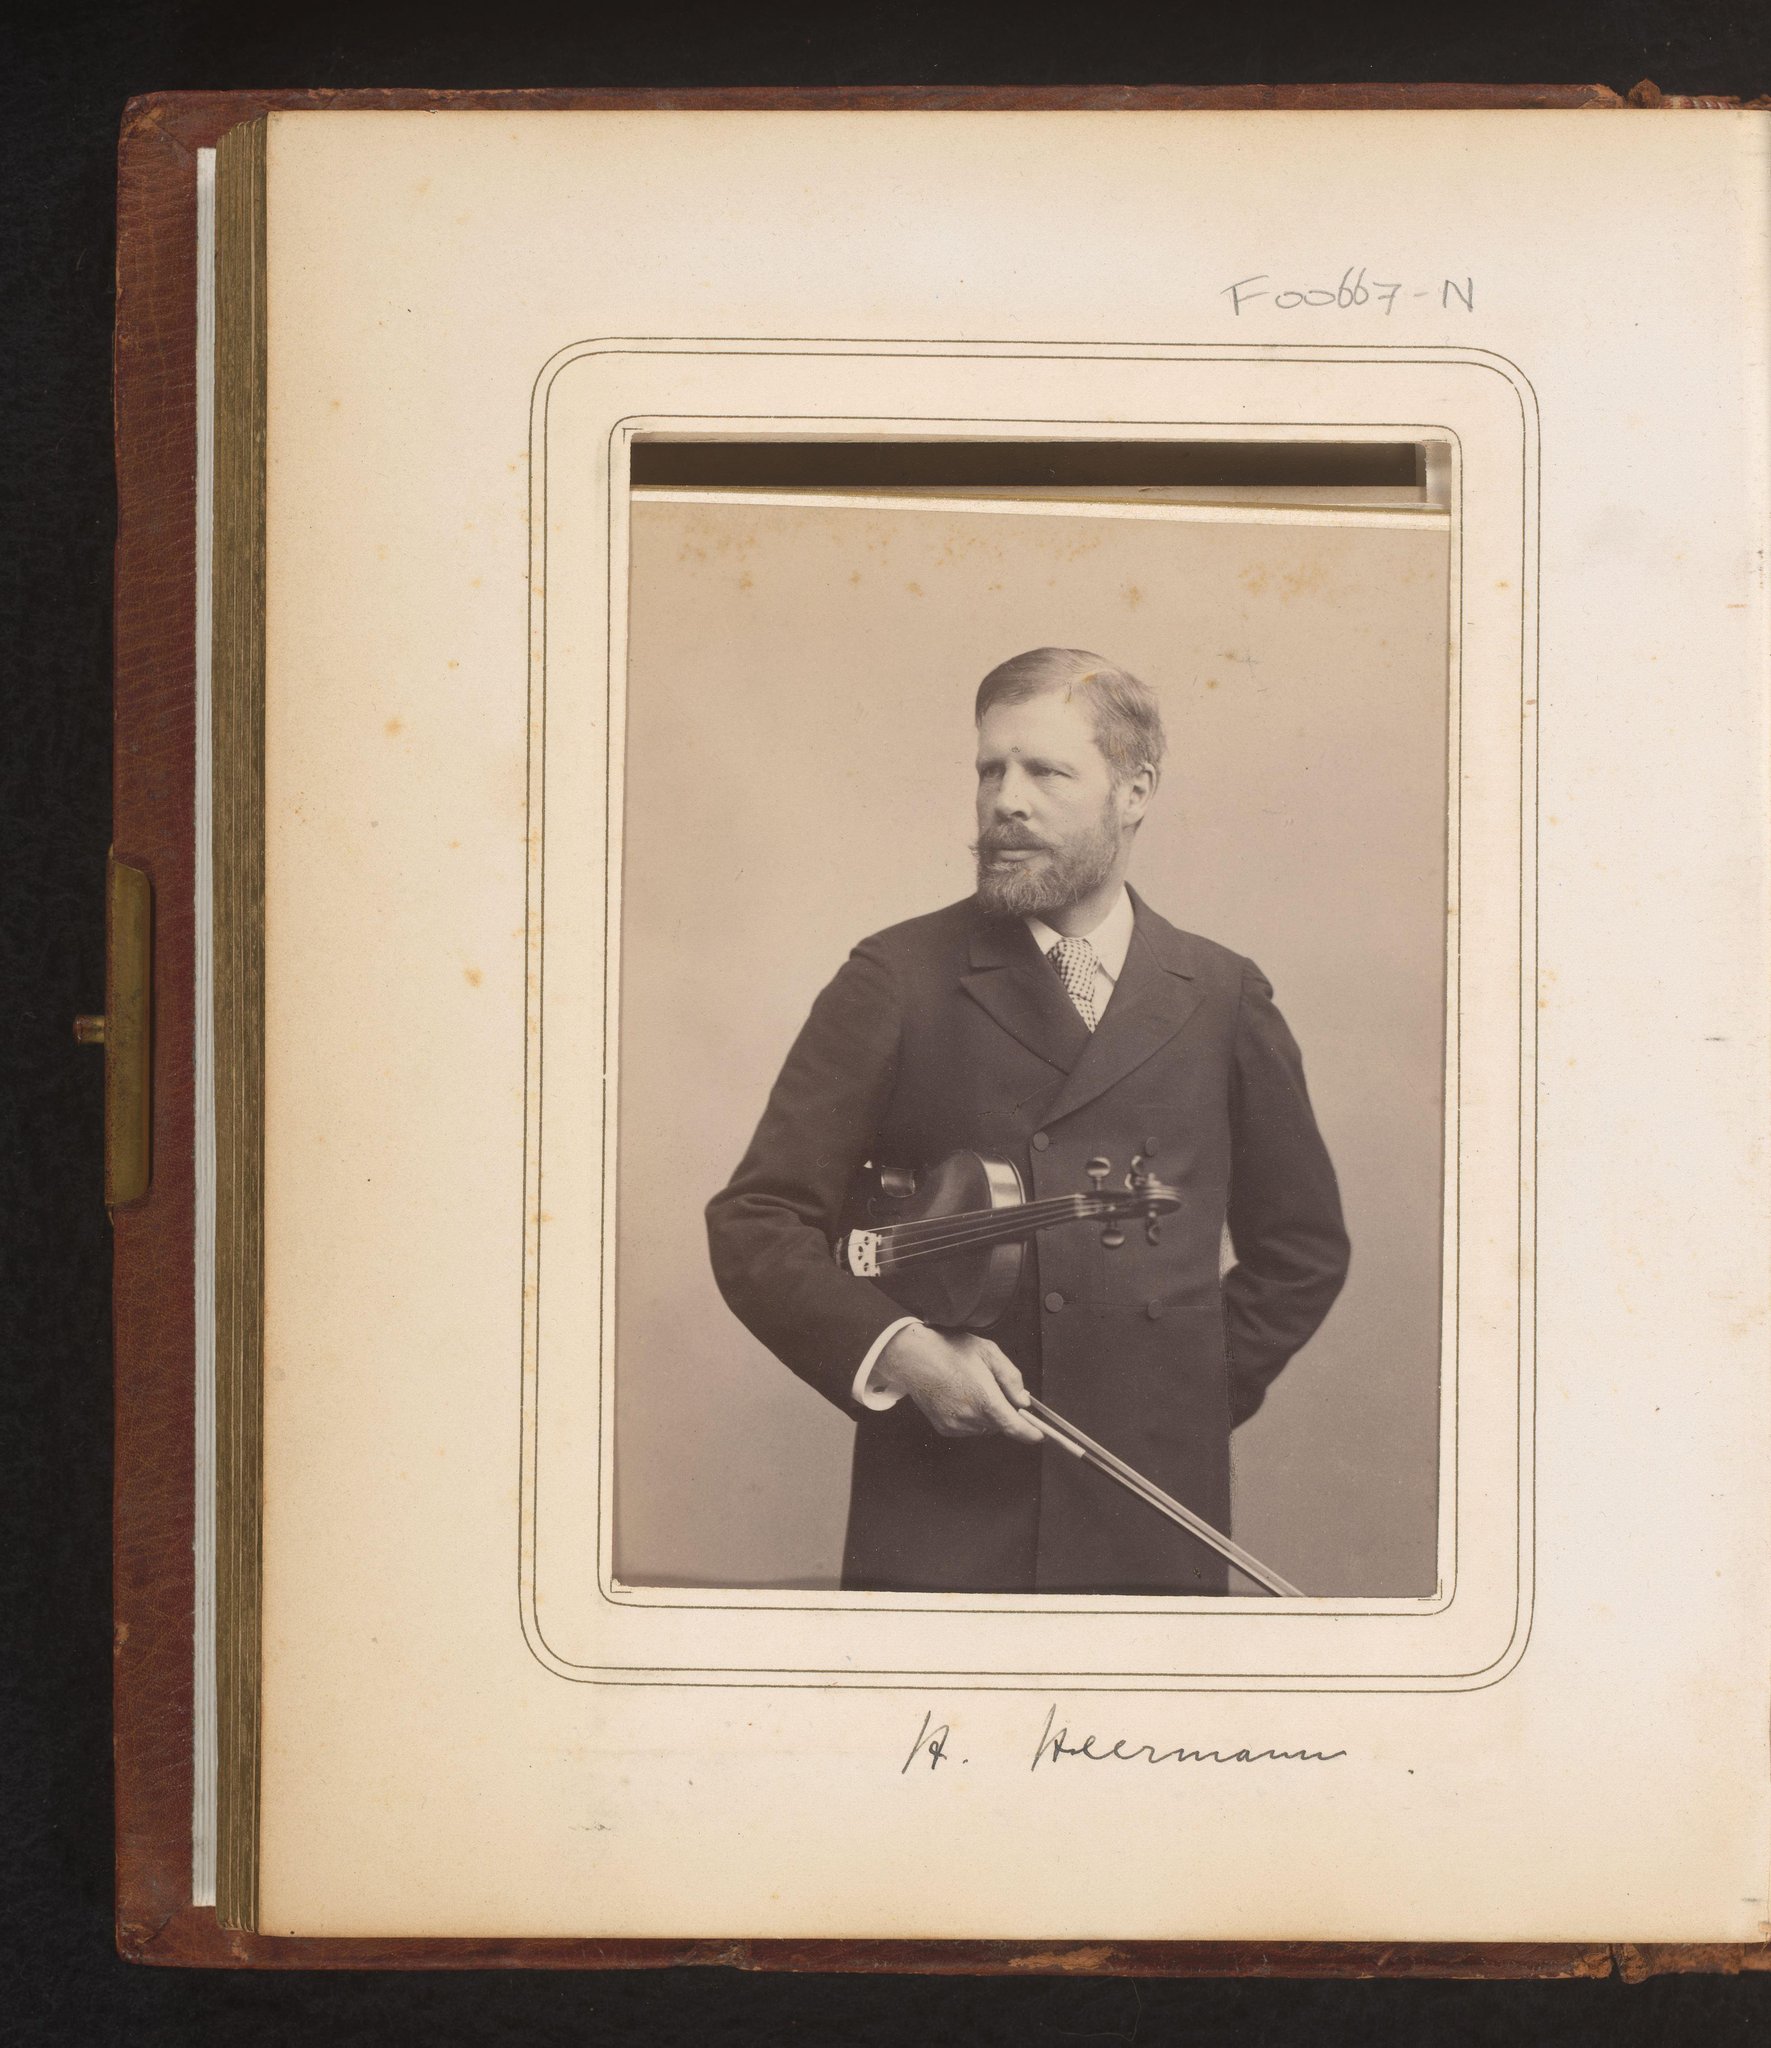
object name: album leaf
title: Portret van Hugo Heermann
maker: erwin hanfstaengl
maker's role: fotograaf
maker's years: 1837-1905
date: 1890-1910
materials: cardboard, photographic support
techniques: albumen print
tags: musician, historical persons, violin, fiddle, portrait of composer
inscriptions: annotation: ‘H. Heermann.’